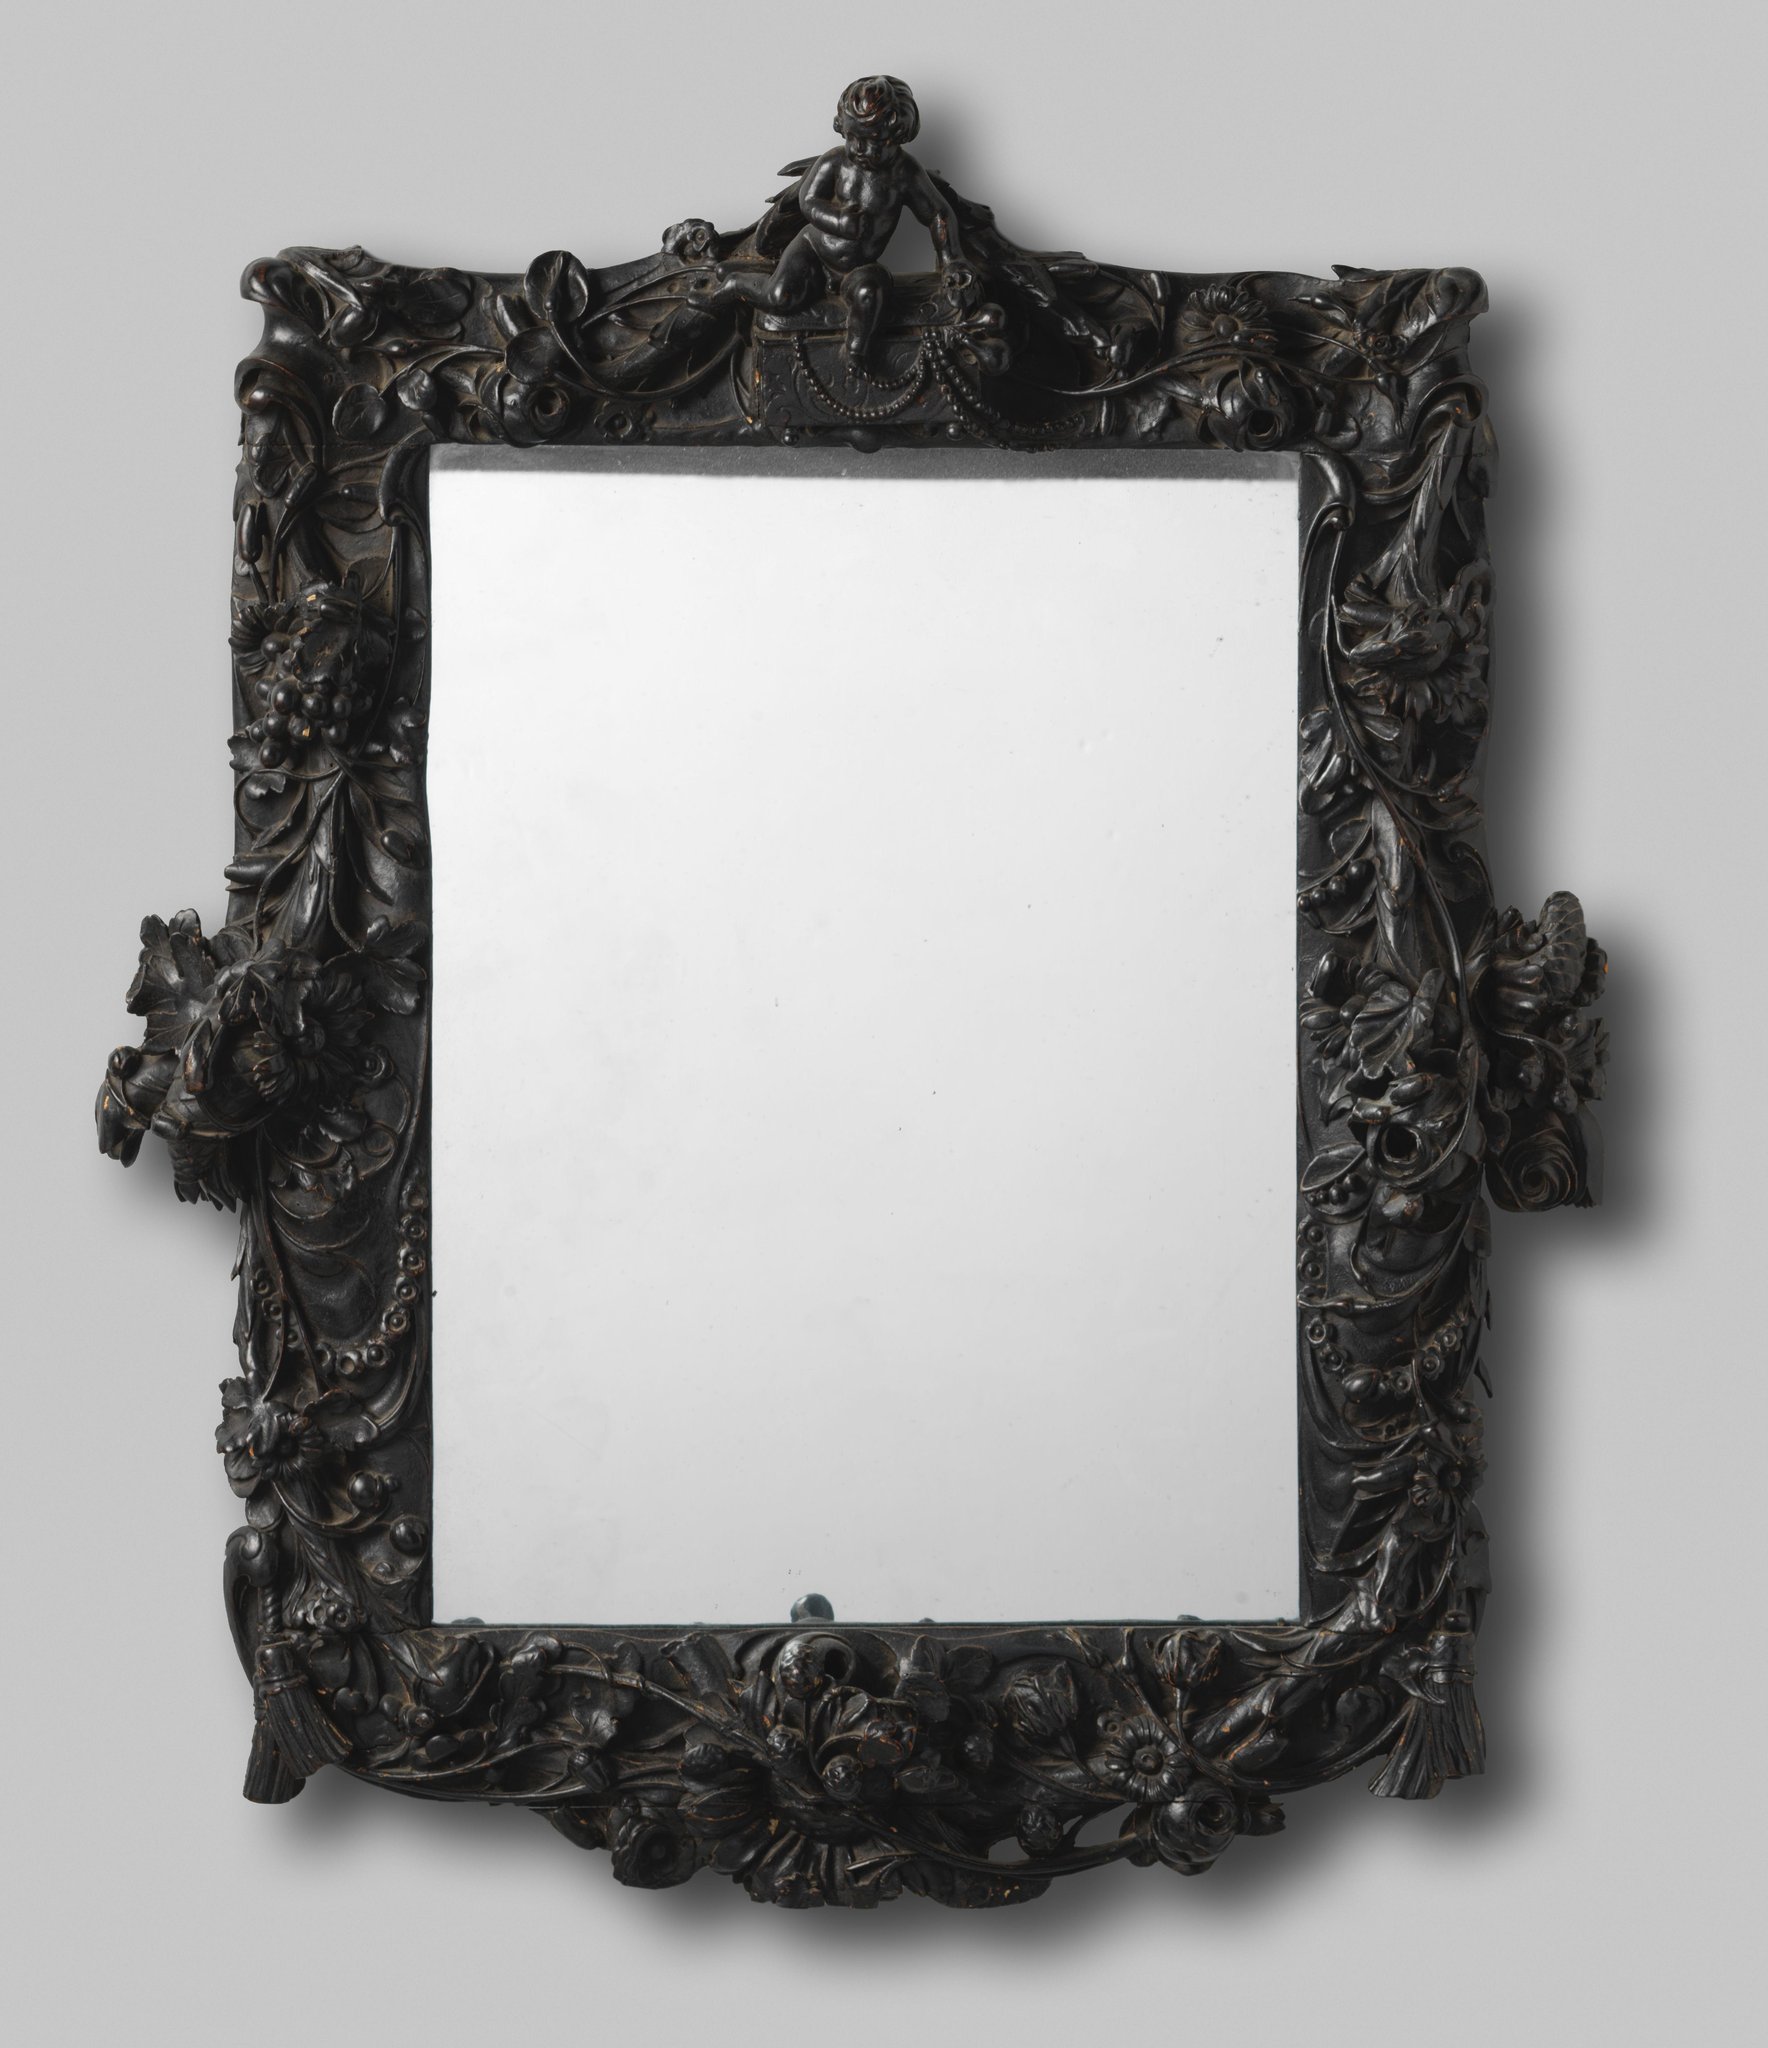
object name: decoratief object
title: Spiegellijst van gebeeldhouwd zwart geverfd lindehout.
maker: Anonymous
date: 1660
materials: wood, paint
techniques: cutting, painting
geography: netherlands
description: Op een uit kwabornament opgebouwde grond zijn bloemen en vruchten aangebracht, die in het midden der linker- en rechterzijde en onderaan in hoog reliëf zijn verenigd. Op de benedenhoeken links en rechts bevinden zich dubbele kwasten. In het midden bovenaan is een cassette aangebracht, waarvan het deksel even geopend is en waaruit colliers afhangen. Bovenop deze cassette zit een putto.